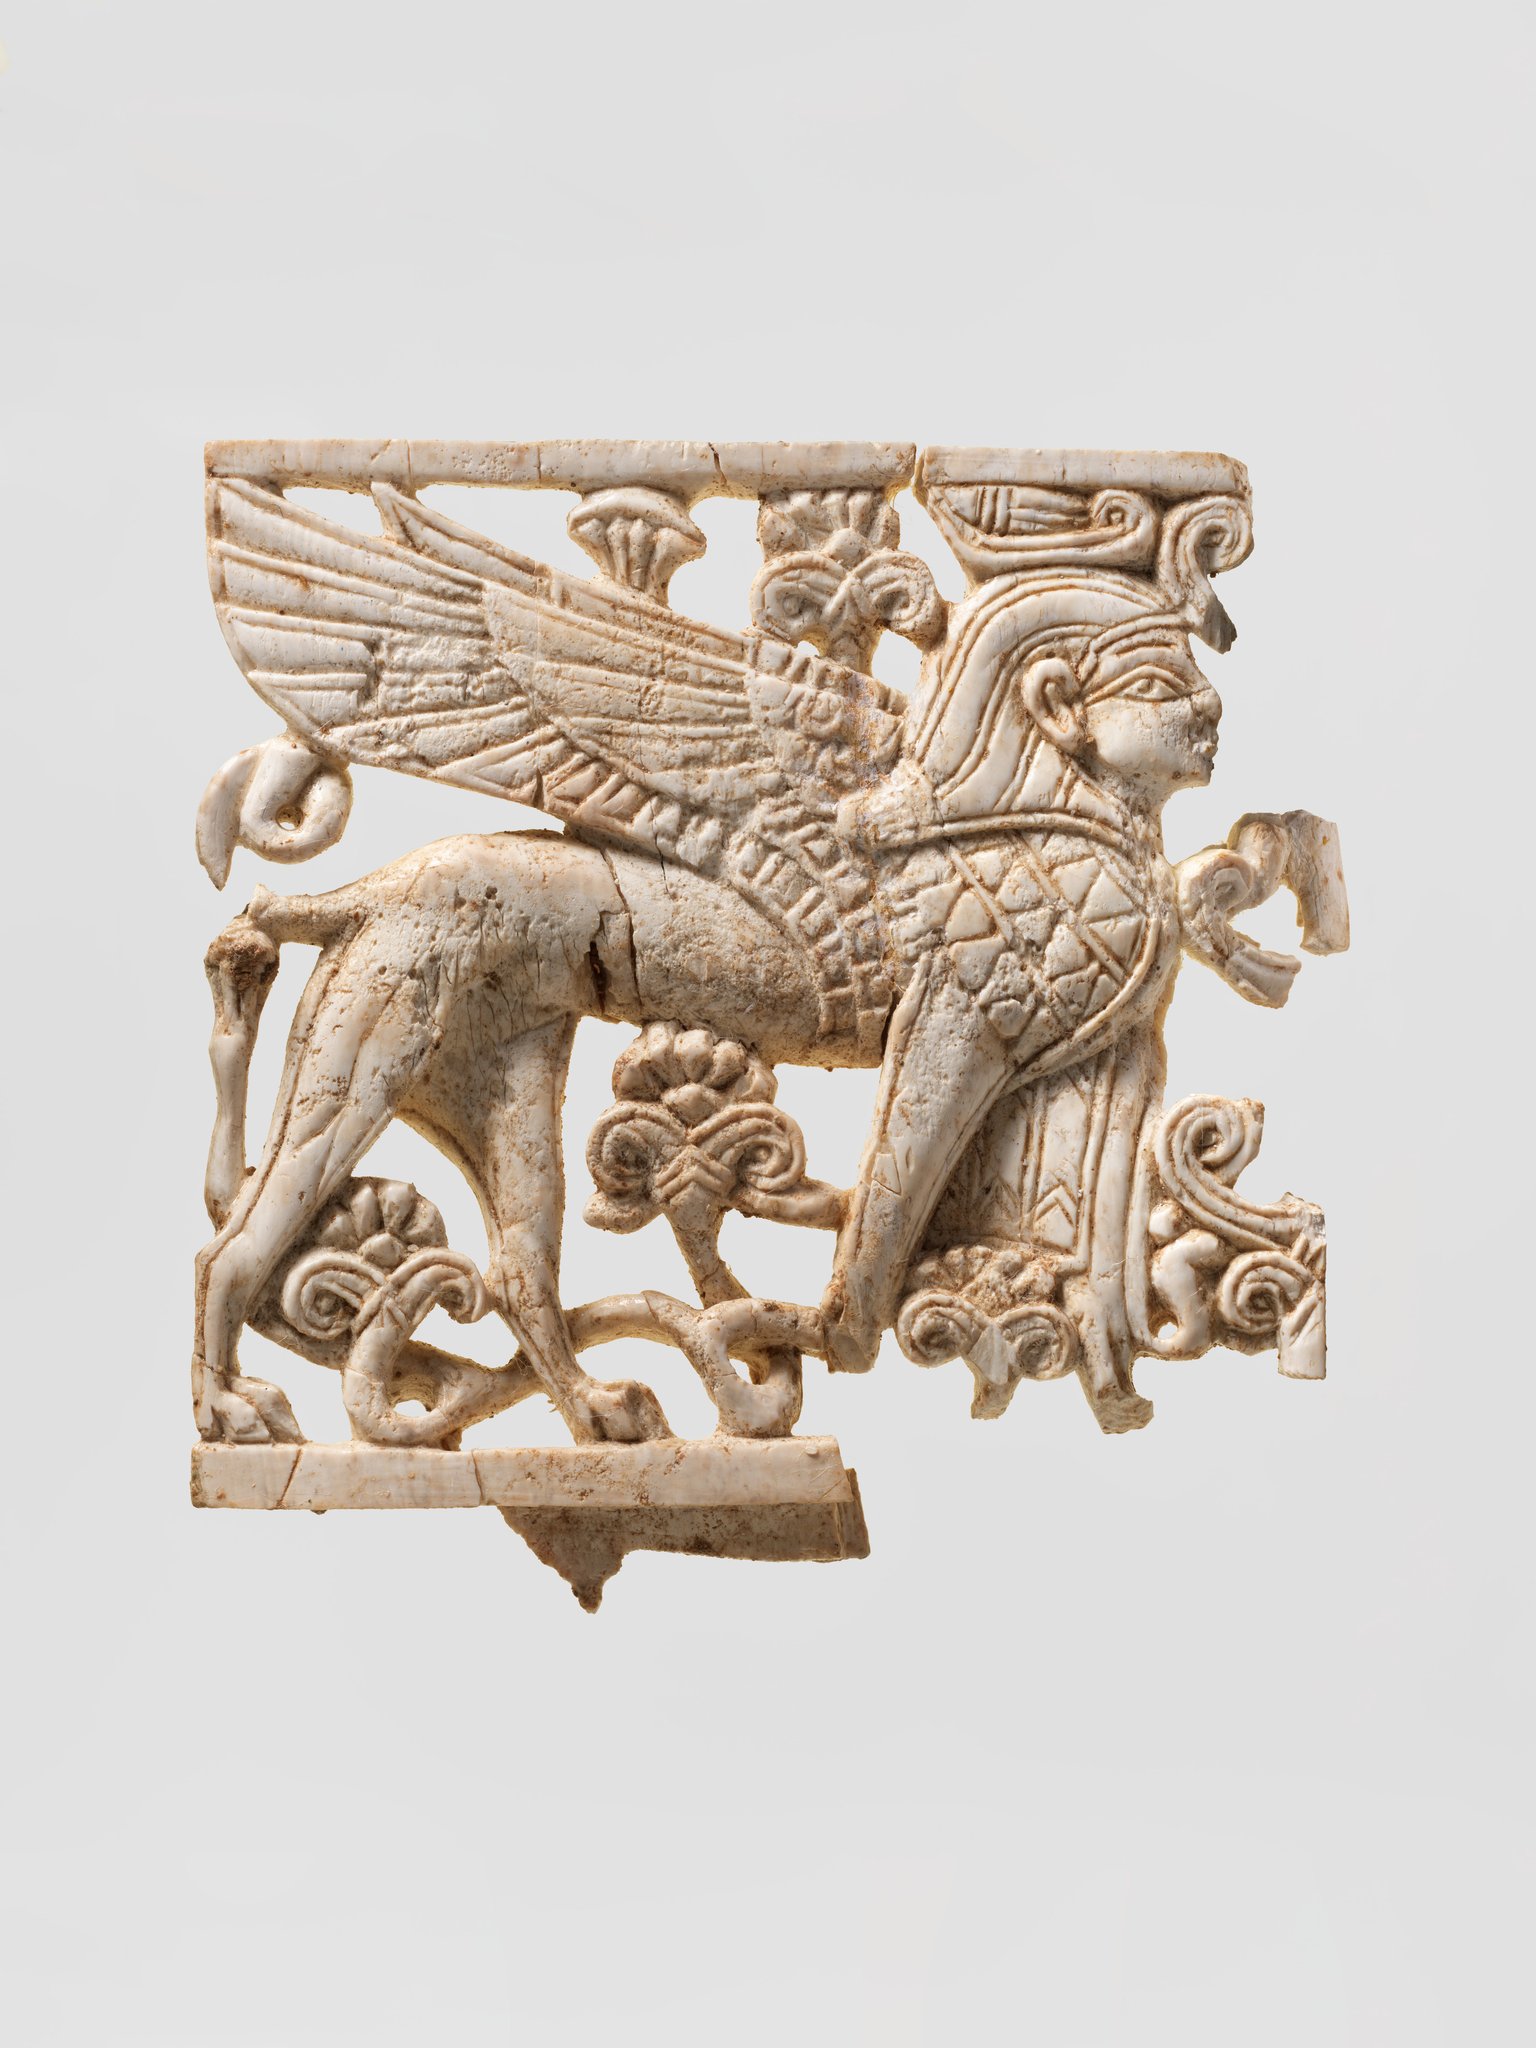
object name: relief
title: Openwork plaque with a sphinx striding through a floral landscape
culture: assyrian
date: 900-701 BCE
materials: ivory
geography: mesopotamia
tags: sphinx